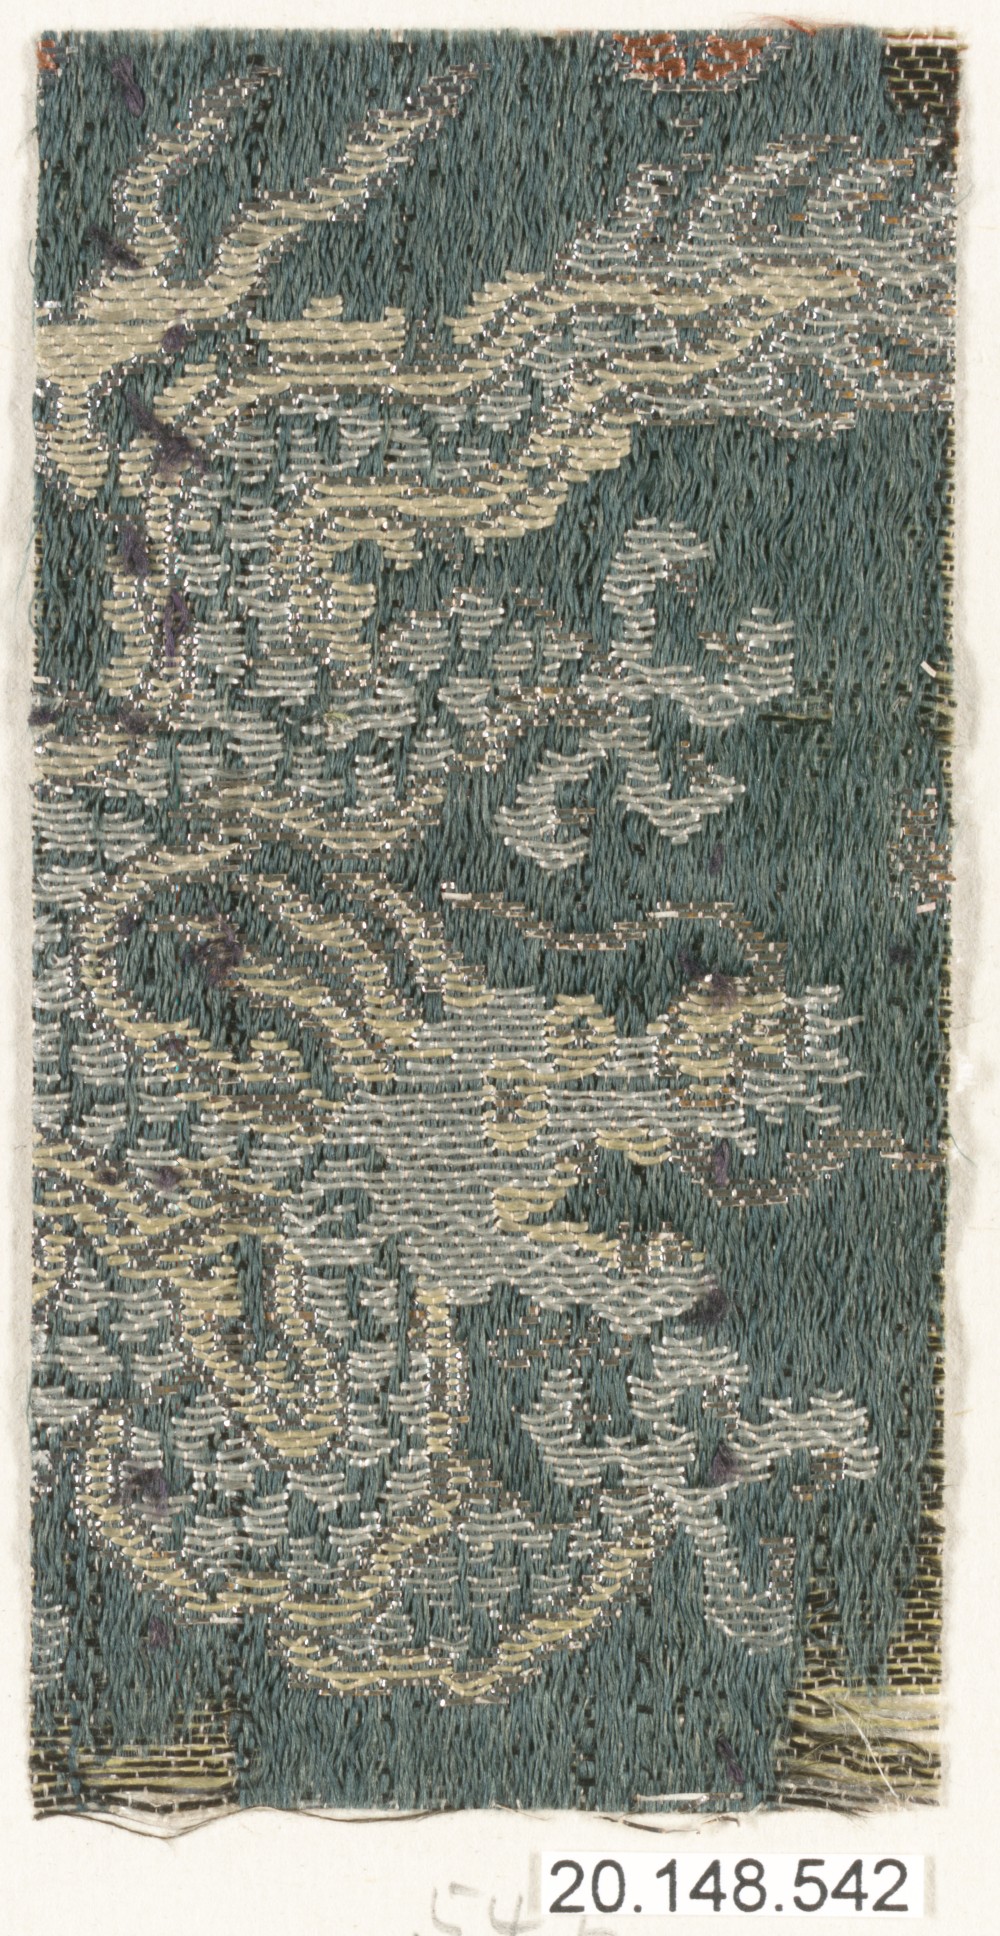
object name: piece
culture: chinese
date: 1701-1800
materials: silk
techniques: compound weave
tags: dragons